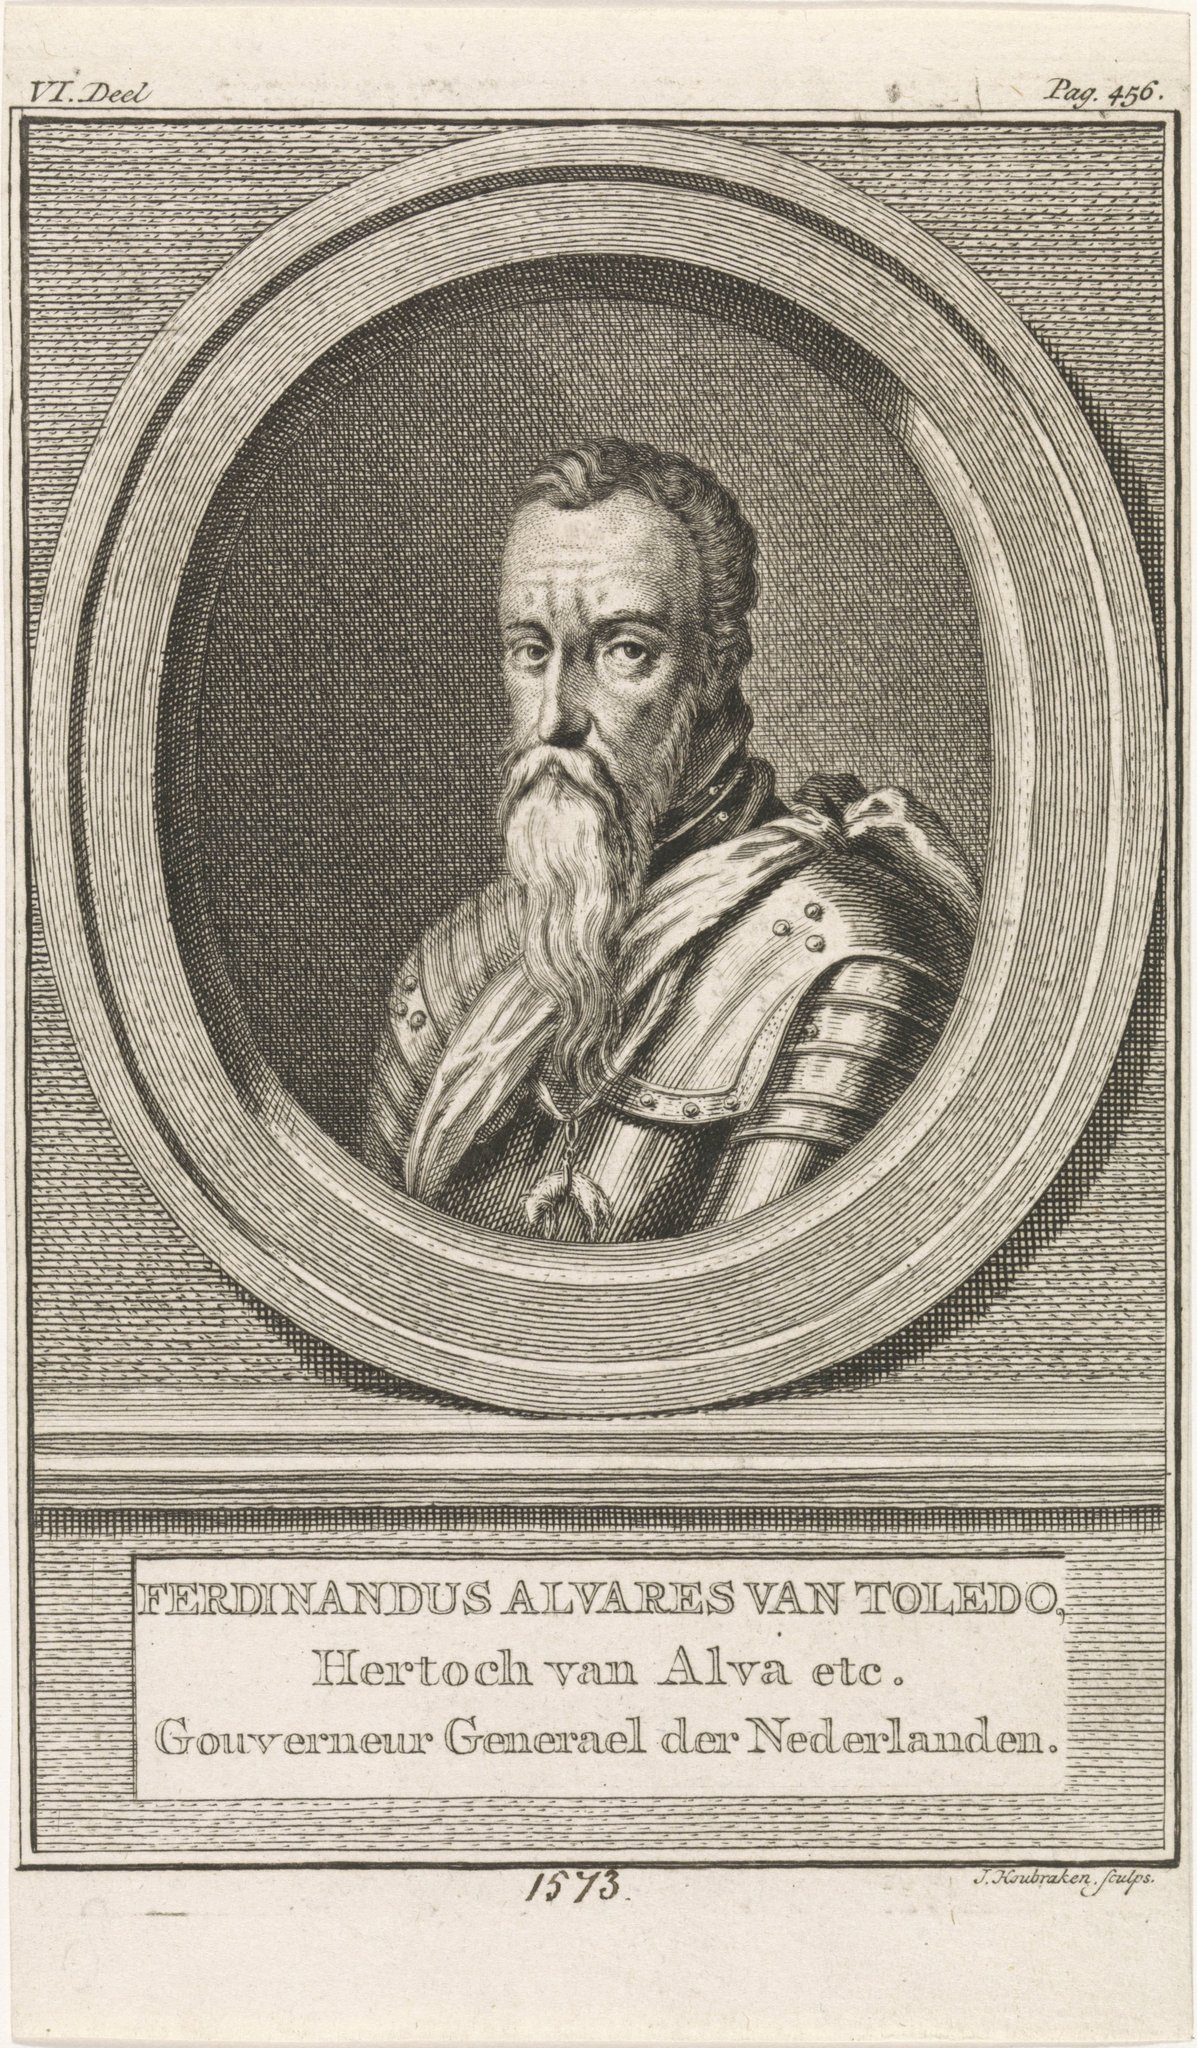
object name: print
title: Portret van Fernando Alvarez de Toledo, hertog van Alva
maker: jacob houbraken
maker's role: draughtsman, print maker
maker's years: 1698-1780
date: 1749-1759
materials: paper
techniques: engraving, pen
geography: amsterdam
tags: fernando álvarez de toledo (3rd duke of alba)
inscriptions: date: ‘1573’, collector's mark: Lugt 2228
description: Buste naar links van Fernando Alvarez de Toledo, hertog van Alva in een ovaal. Het portret rust op een plint waarop zijn naam en gegevens in drie regels in het Nederlands. Linksboven: VI. Deel en rechtsboven: Pag. 456.